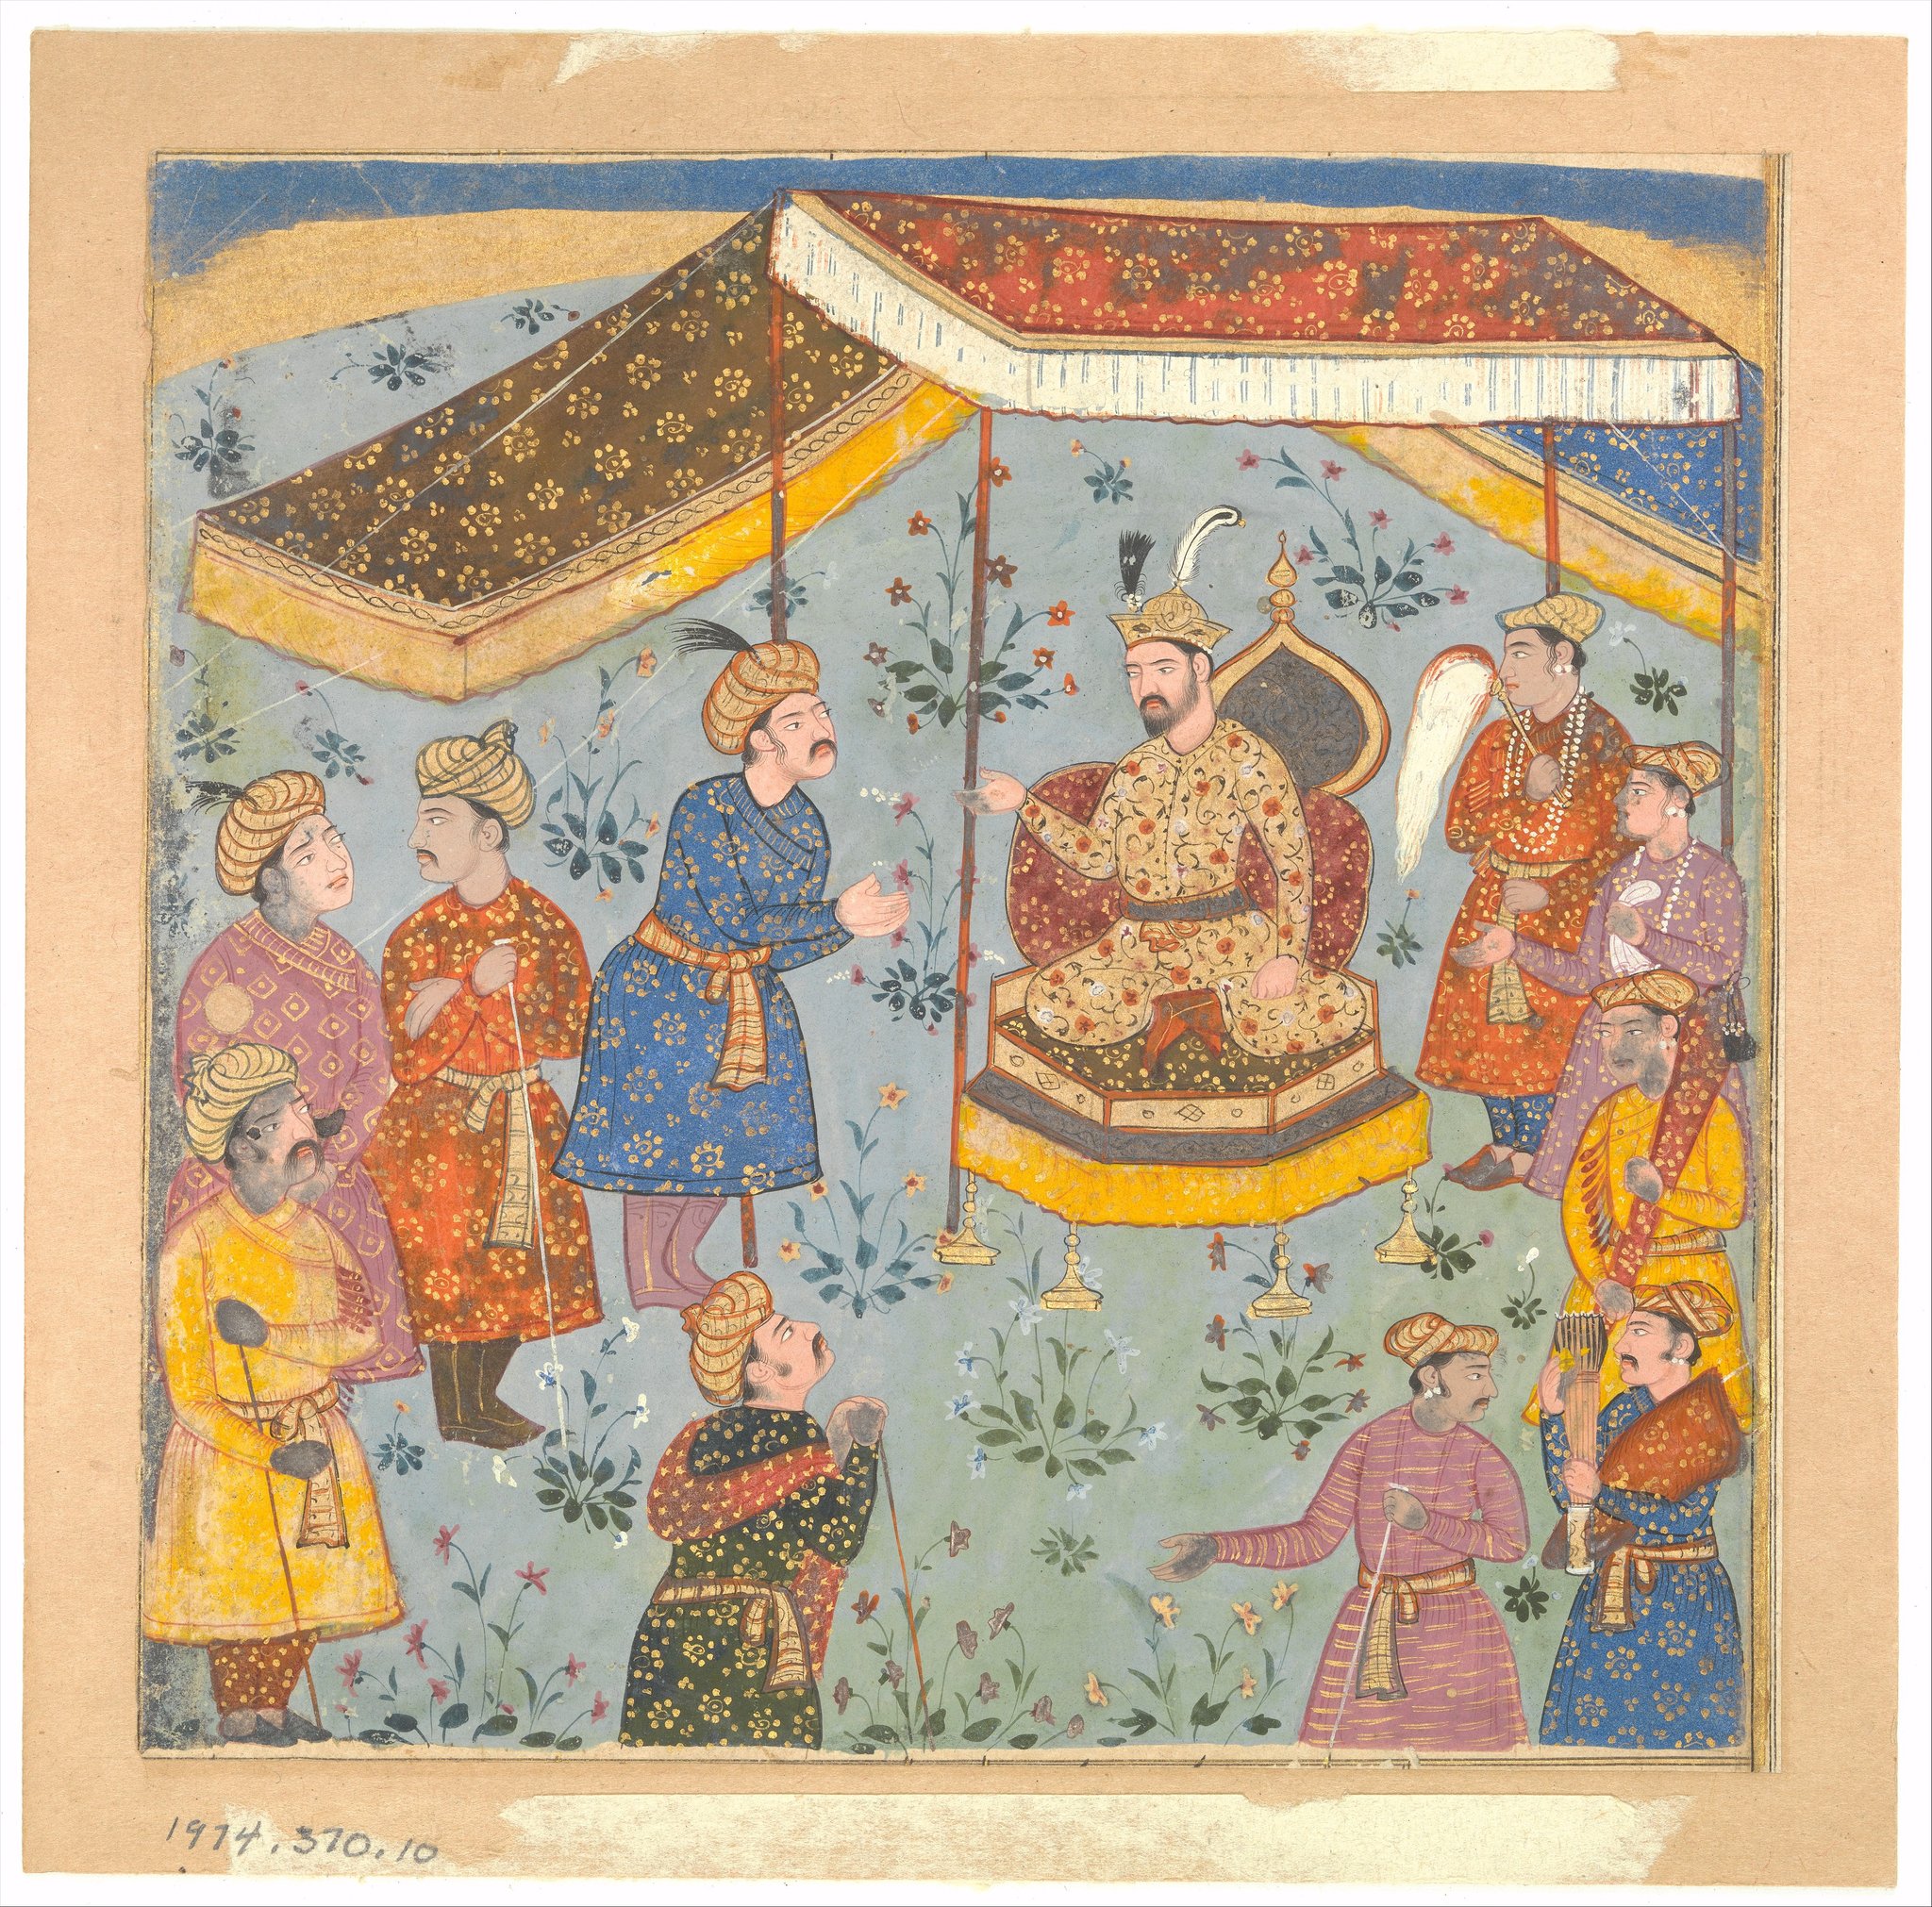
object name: illustrated album leaf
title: Reception of a Persian Ambassador by a Mughal Prince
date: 1601-1633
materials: gold, paper, watercolor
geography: india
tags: princes,men